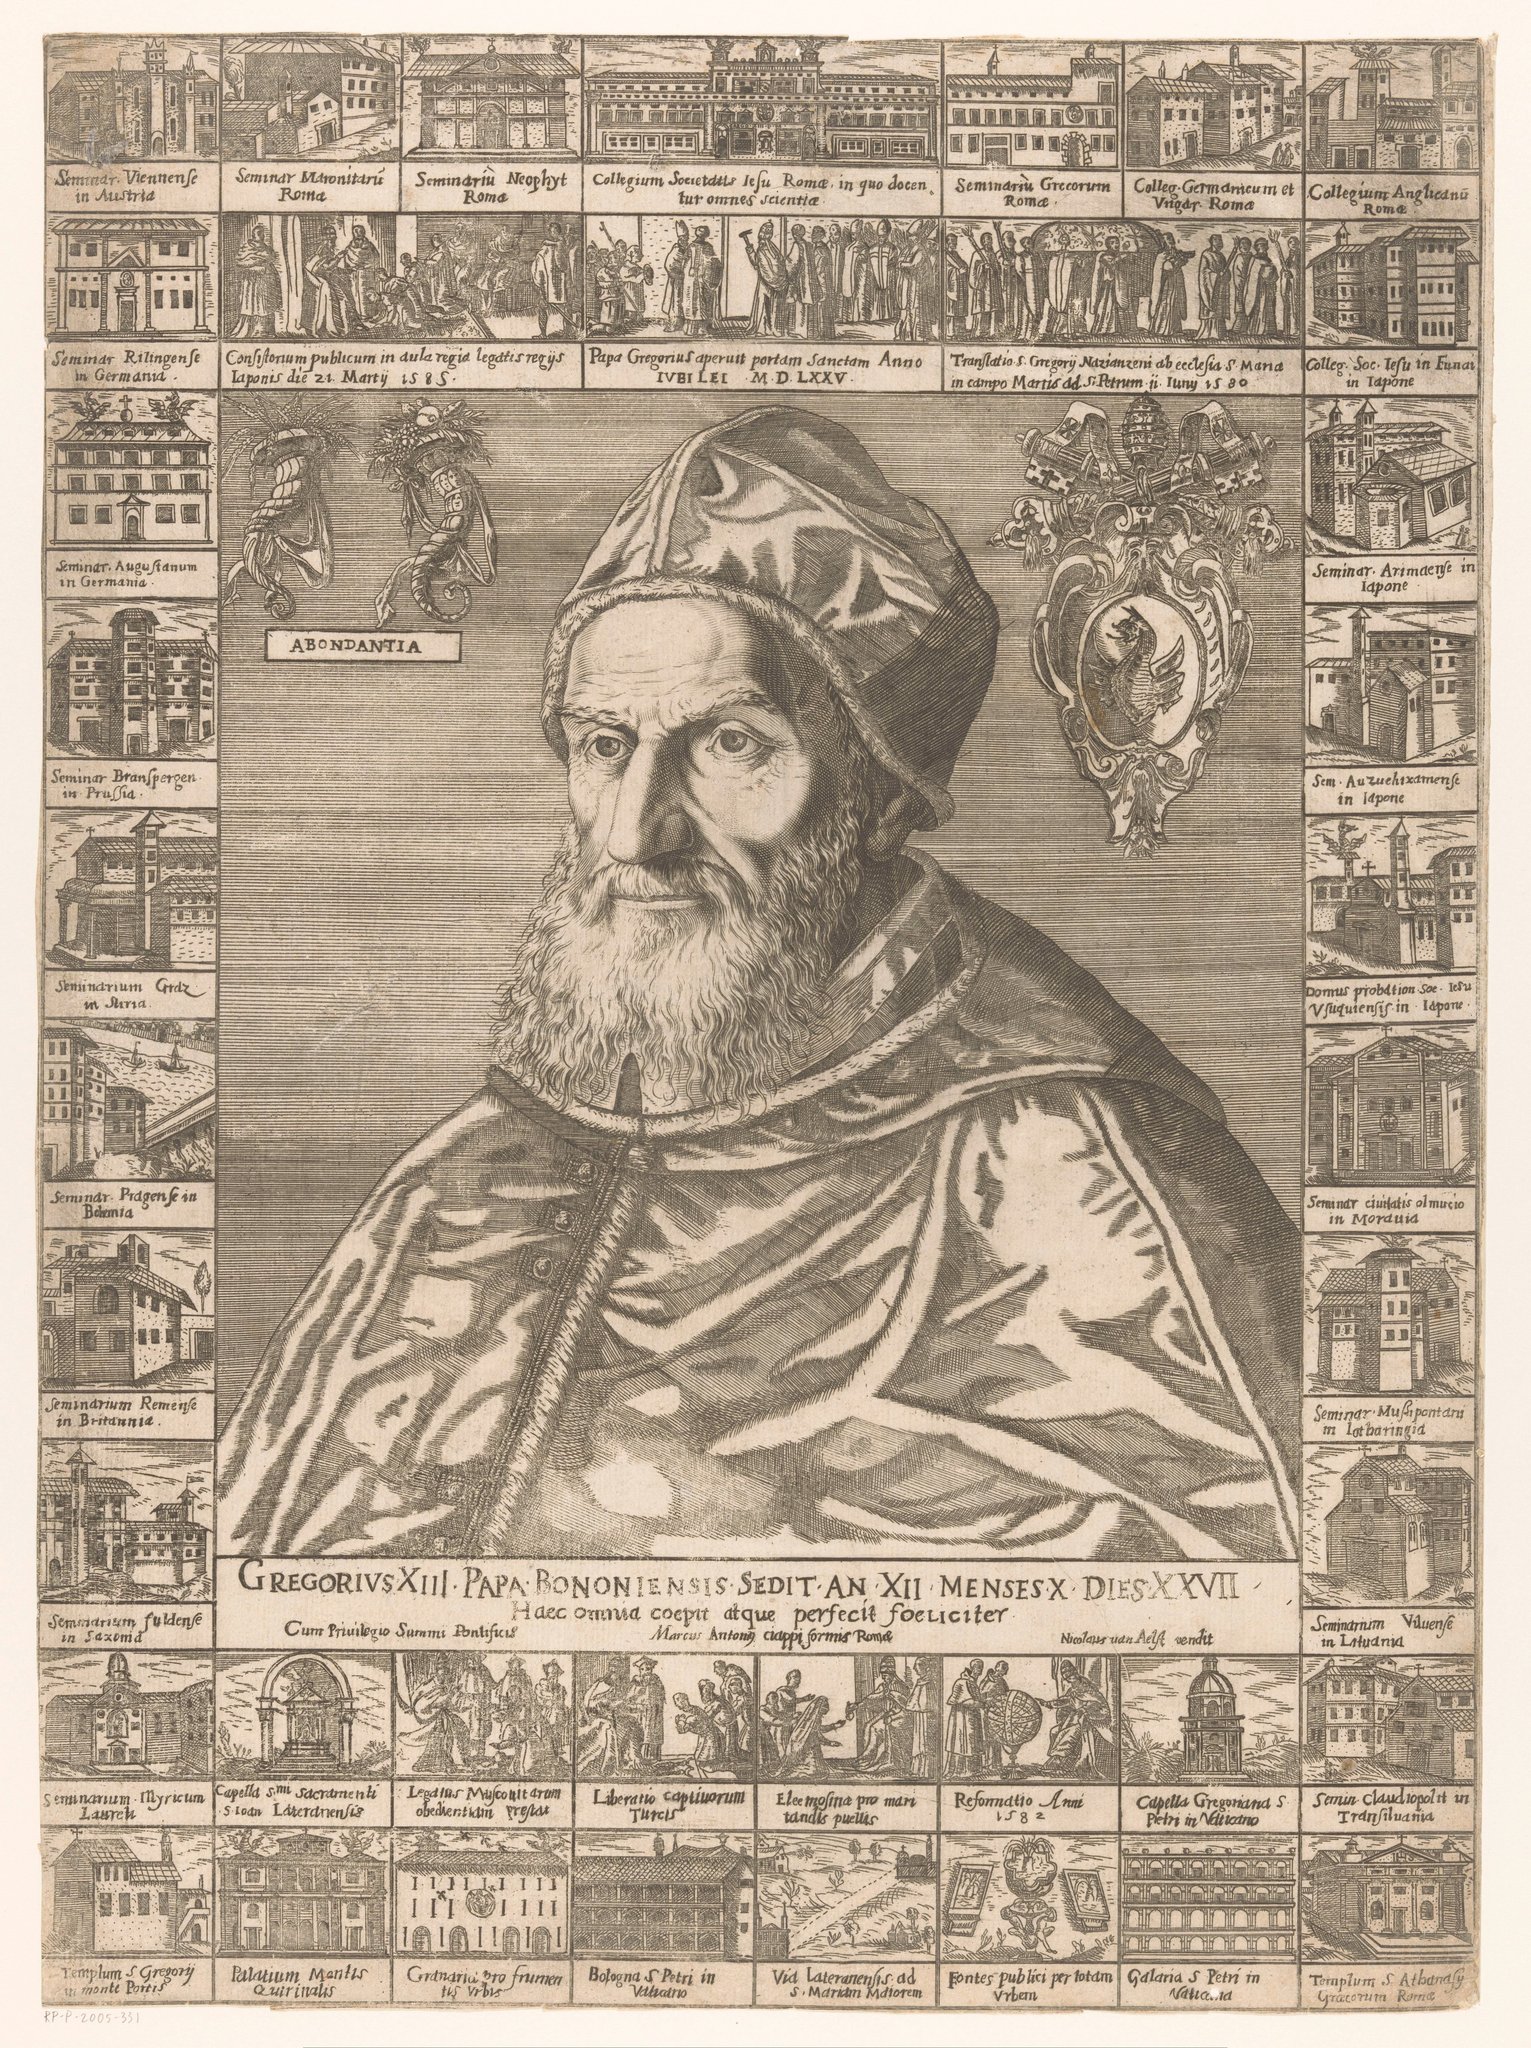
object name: print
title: Portret van paus Gregorius XIII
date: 1582-1585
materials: paper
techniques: engraving, etching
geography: rome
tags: rome, gregorius xiii, 'cornucopia', horn of plenty, historical persons, pope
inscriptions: collector's mark: Lugt 2760, collector's mark: Lugt 2228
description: Portret paus Gregorius XIII, omringd door gebeurtenissen tijdens zijn pontificaat en bouwwerken die tijdens zijn pontificaat tot stand werden gebracht. Linksboven twee keer een hoorn des overvloeds (cornucopia) met daaronder de tekst 'Abondantia'. Rechtsboven het wapen van de paus.